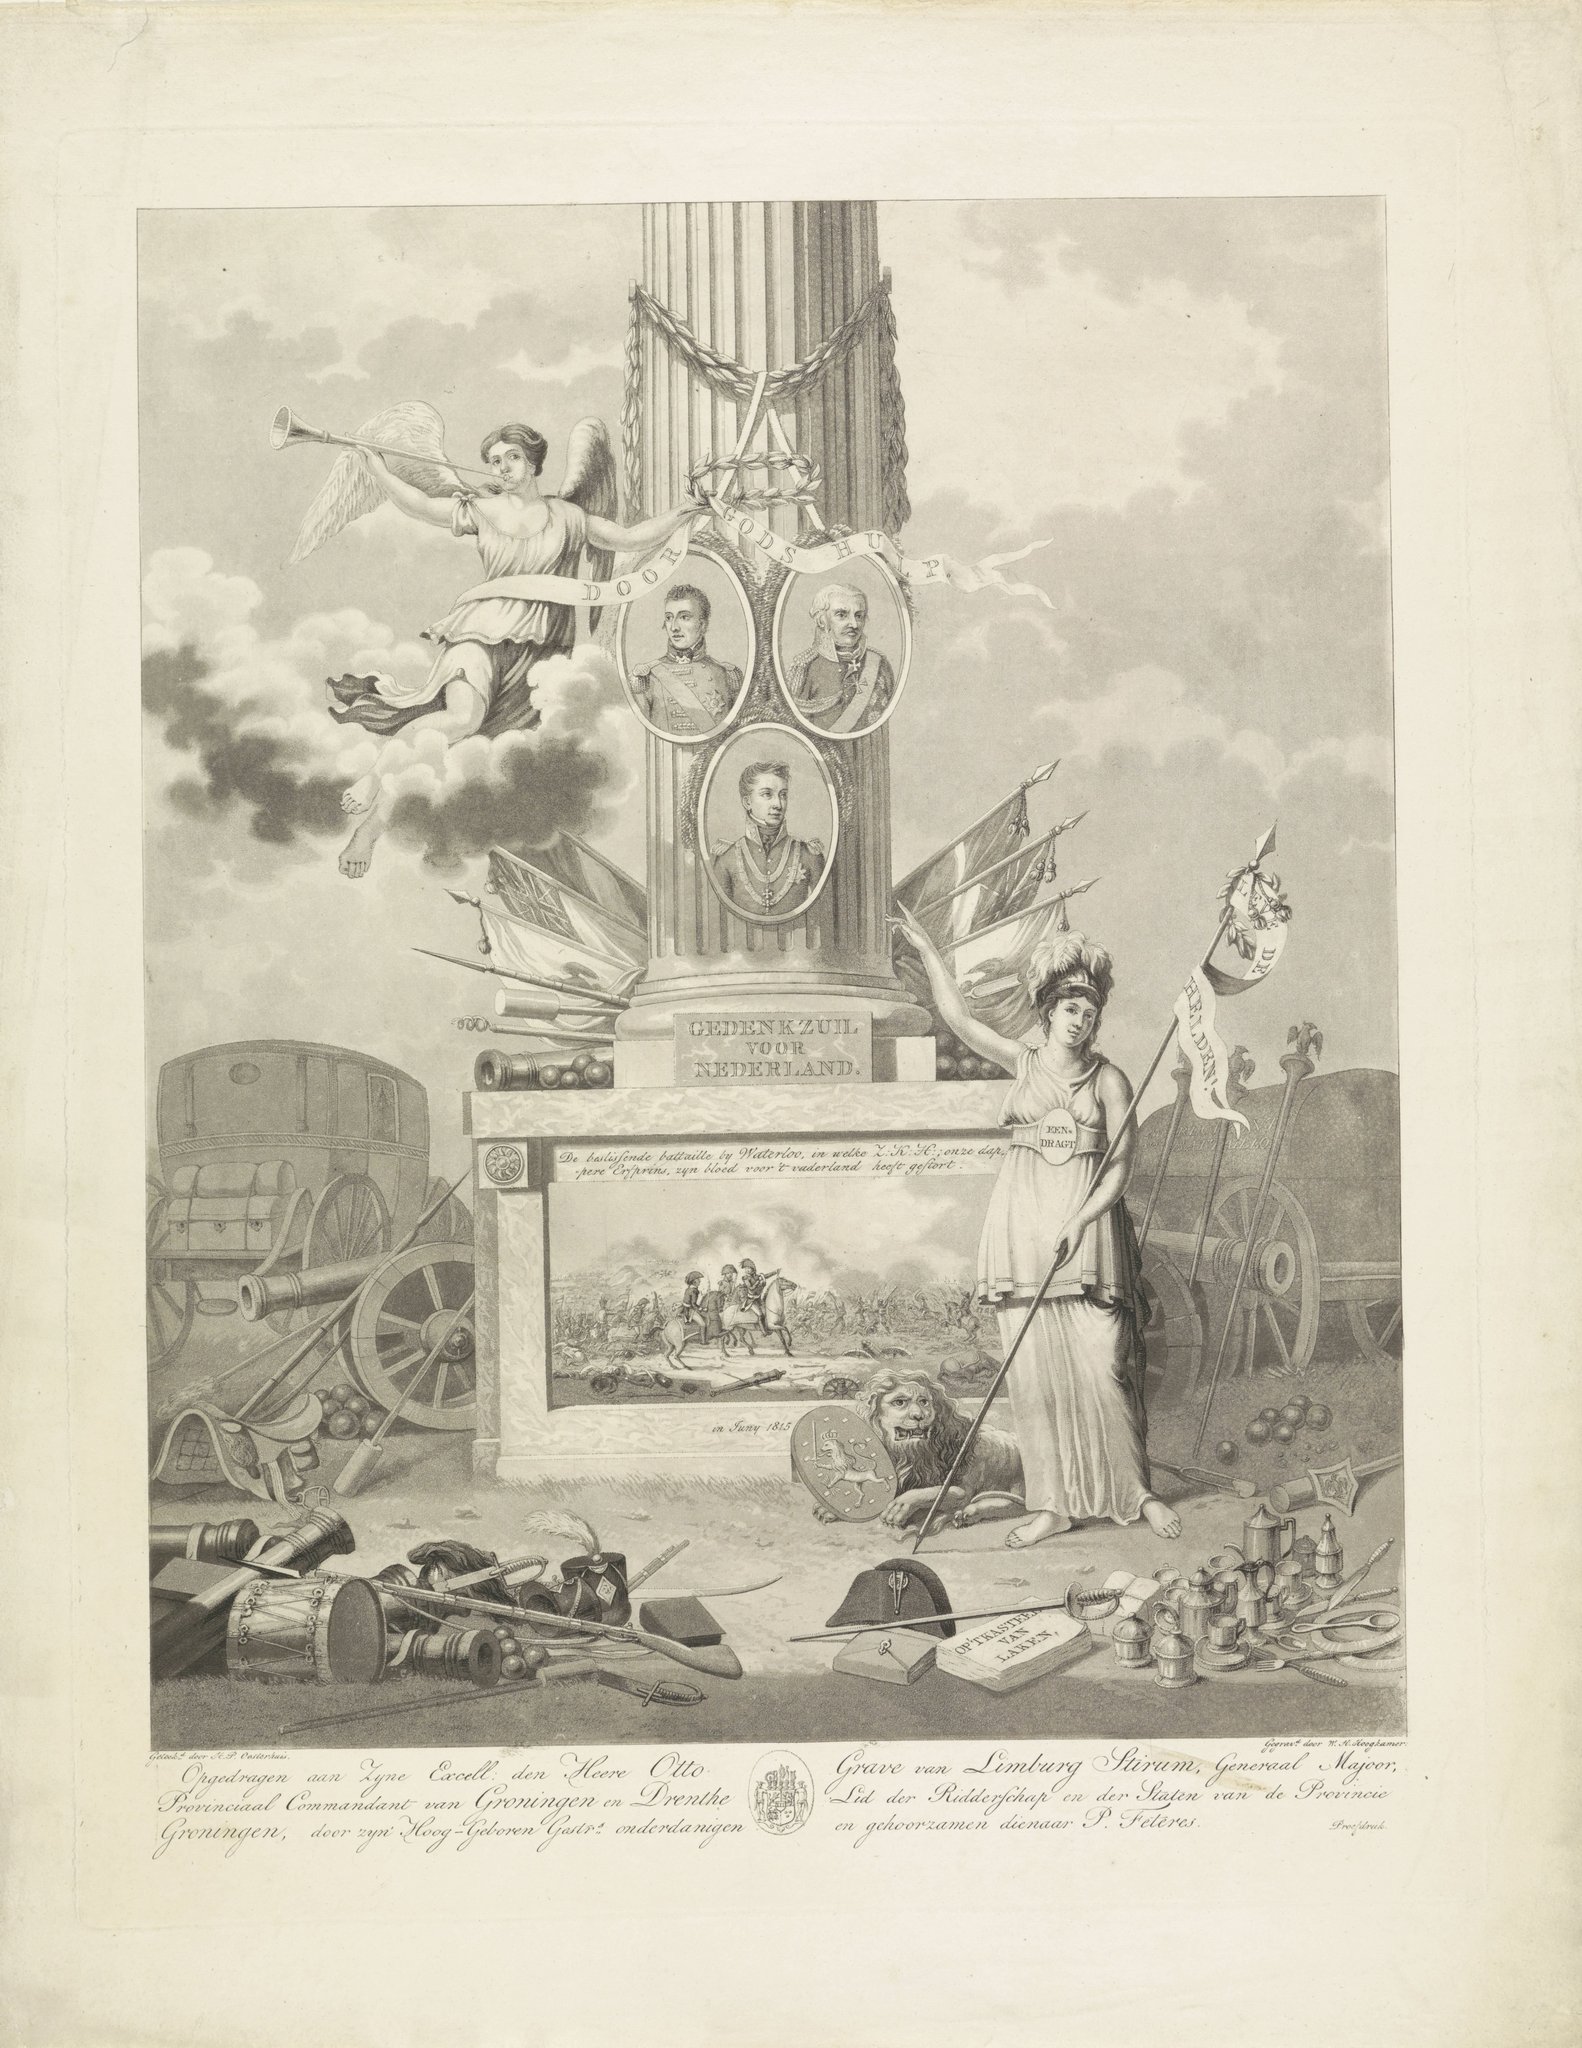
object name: print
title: Allegorie op de helden van de slag bij Waterloo, 1815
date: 1815-1820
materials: paper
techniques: aquatint, etching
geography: netherlands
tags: the hague, william ii of the netherlands, walmer castle, arthur wellesley of wellington, fame; 'fama', 'fama buona', 'fama chiara' (ripa), battle (+ land forces), alliance, league, union, foedus, waterloo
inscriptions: collector's mark: Lugt 2228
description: Allegorie op de overwinning van de bondgenoten in de Slag bij Waterloo op 18 juni 1815. Centraal een zuil waaraan de portretten van Wellingon , Blücher en de prins van Oranje. Onderaan de zuil een voorstelling van de slag bij Waterloo van 18 juni 1815. In de lucht blaast de Faam op haar bazuin. Rechts bij de zuil staat de Eendracht die wijst naar de portretten van de drie helden, aan haar voeten de Nederlandse leeuw. Vooraan op de grond wapens en huisraad en een bundel papier gemerkt 'op 't kasteel van Laken', linksachter de veroverde reiskoets van Napoleon. Met drieregelig onderschrift.